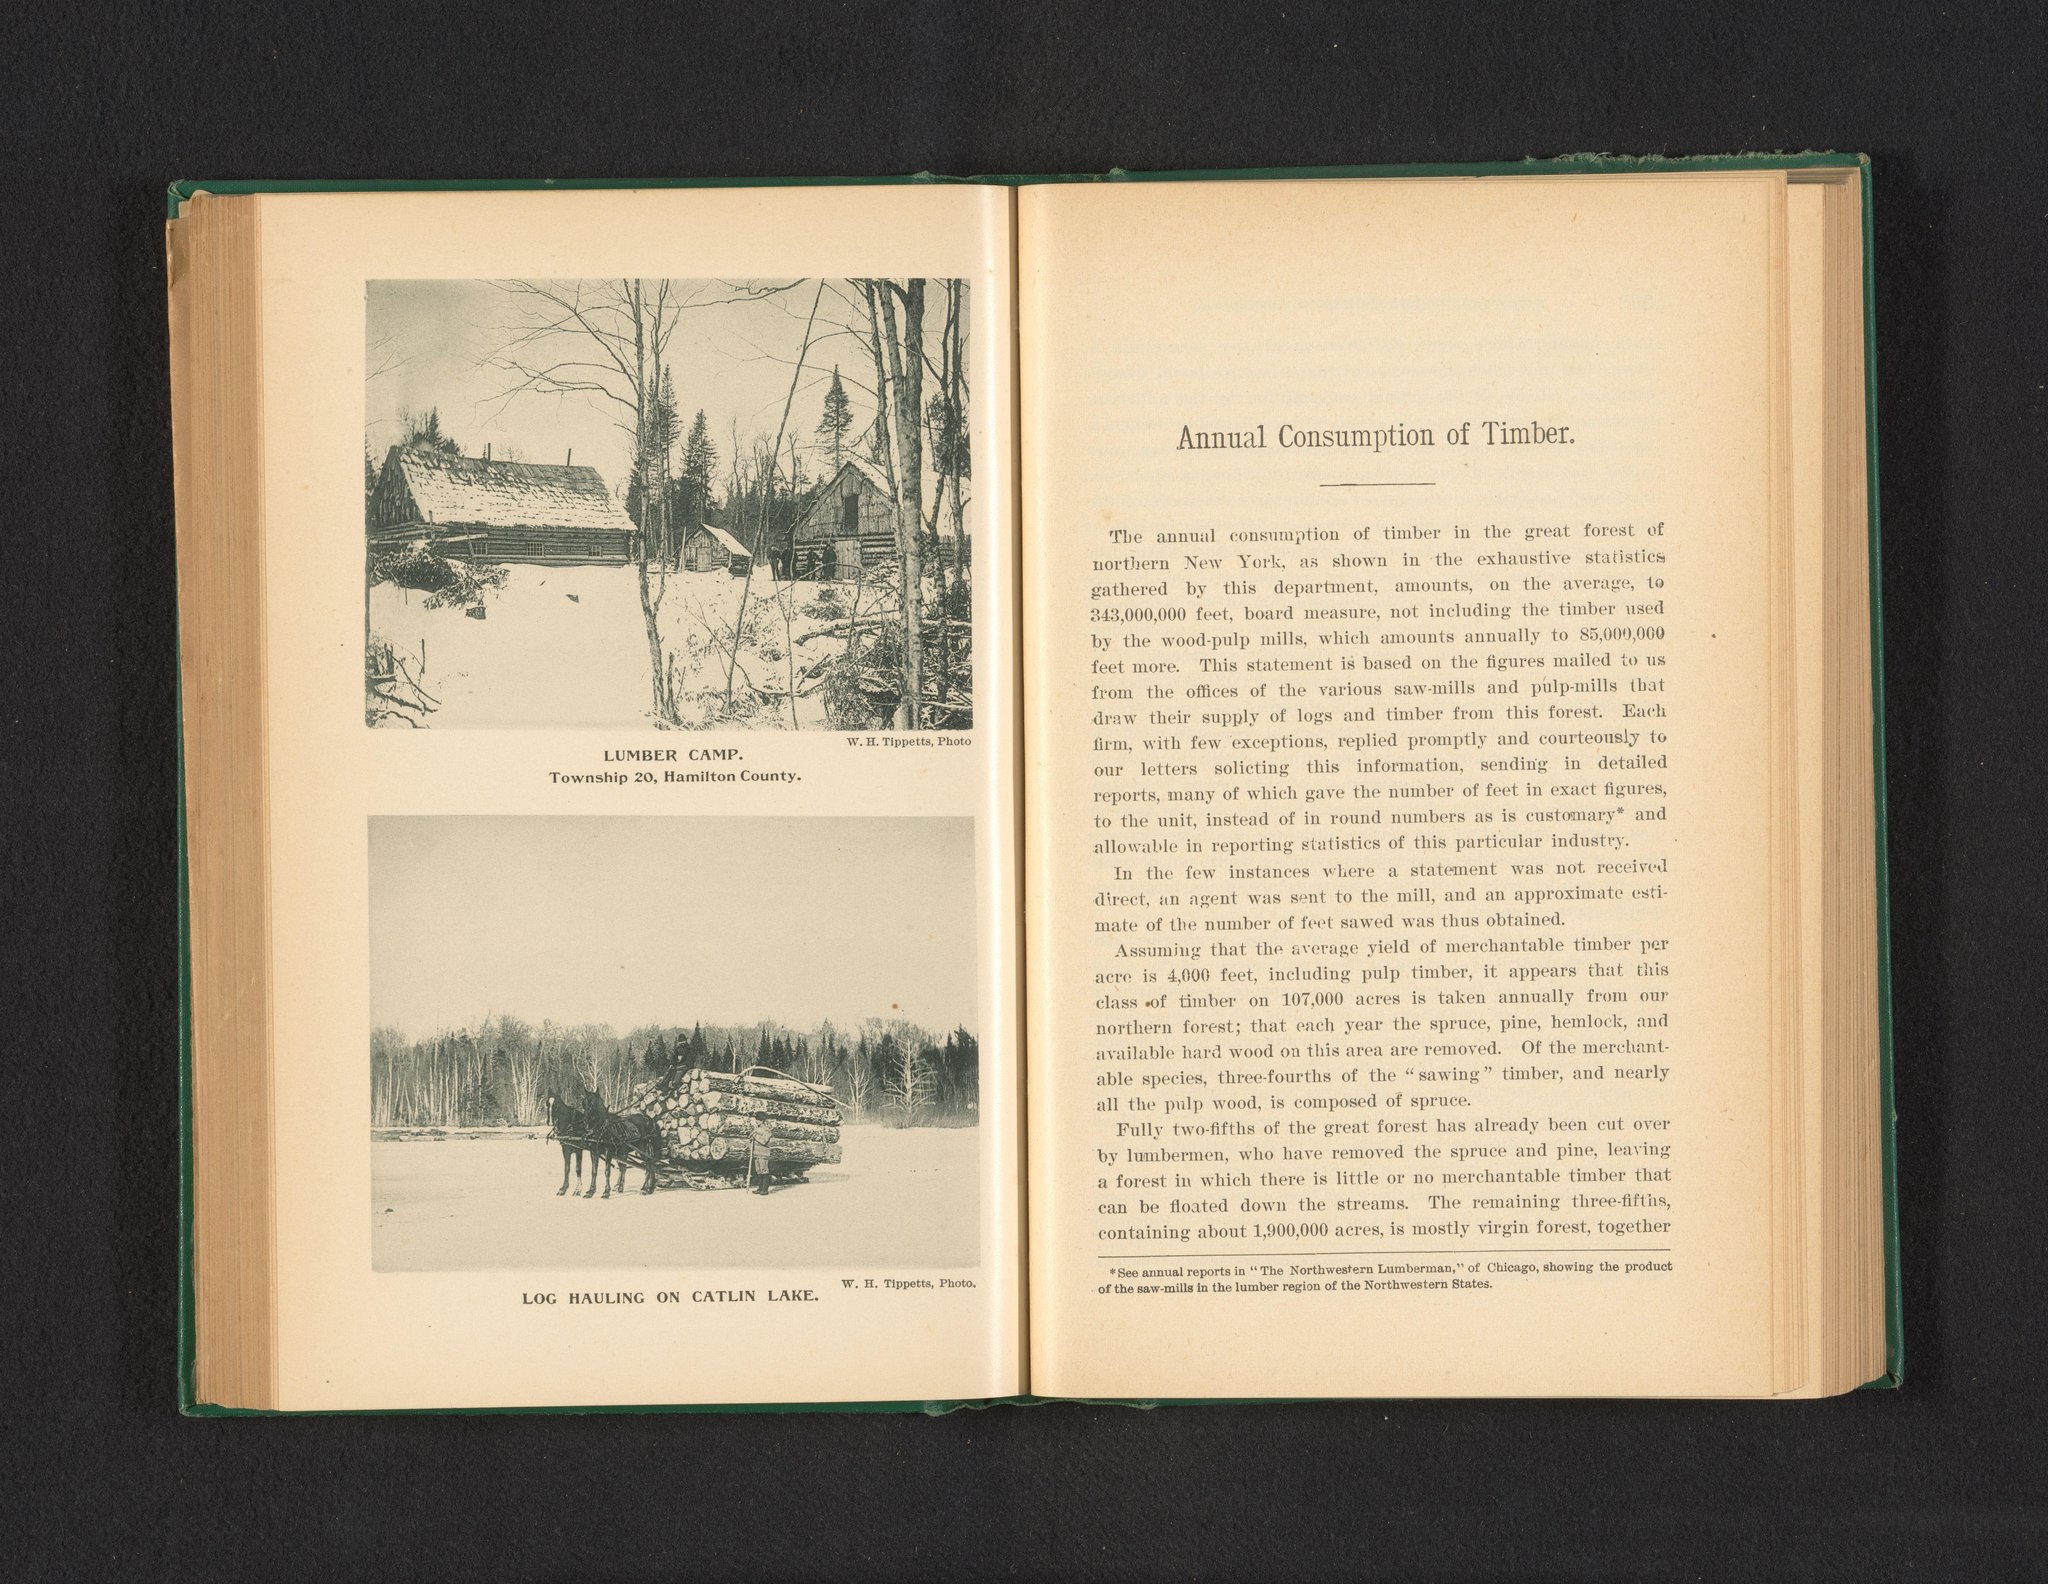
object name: page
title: Lumber Camp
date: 1893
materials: paper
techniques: photograph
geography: new york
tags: horse-sleigh, timber yard, lumber stack, beam, log of wood